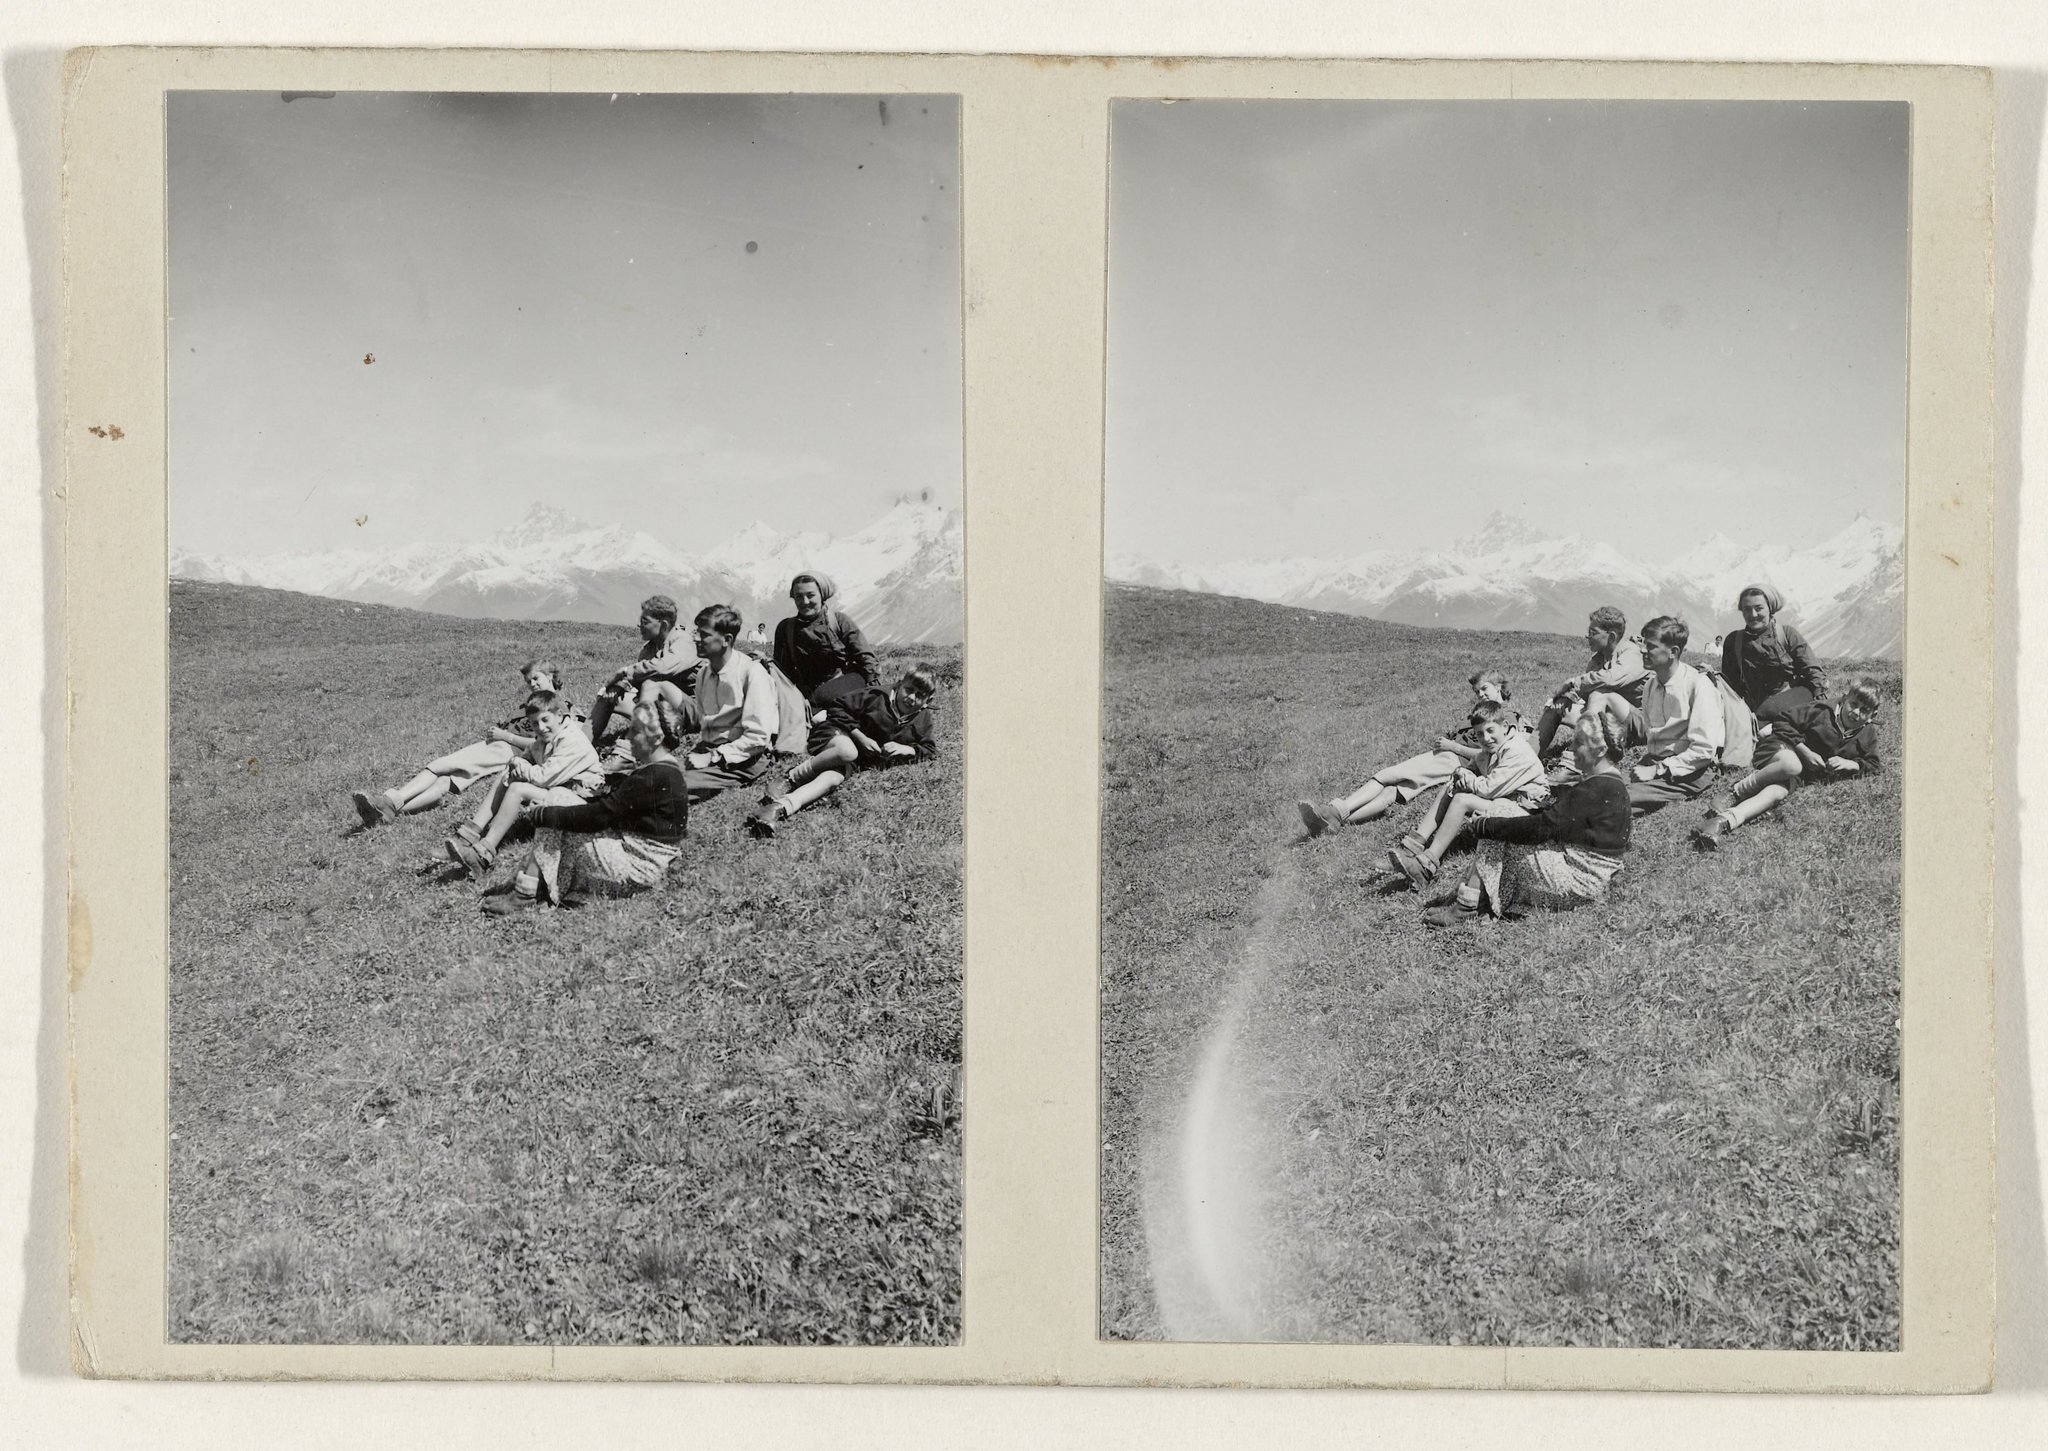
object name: stereograph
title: Rustende mensen op een grasveld temidden van besneeuwde heuveltoppen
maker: geldolph adriaan kessler (dolph)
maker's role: fotograaf, industrieel, voetballer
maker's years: 1884-1945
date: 1920-1945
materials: paper, photographic support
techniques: collodion silver print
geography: netherlands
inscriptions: title: ‘Op het colletje N van de Alla uitzicht op de Piz Kesch Piz Urz.’